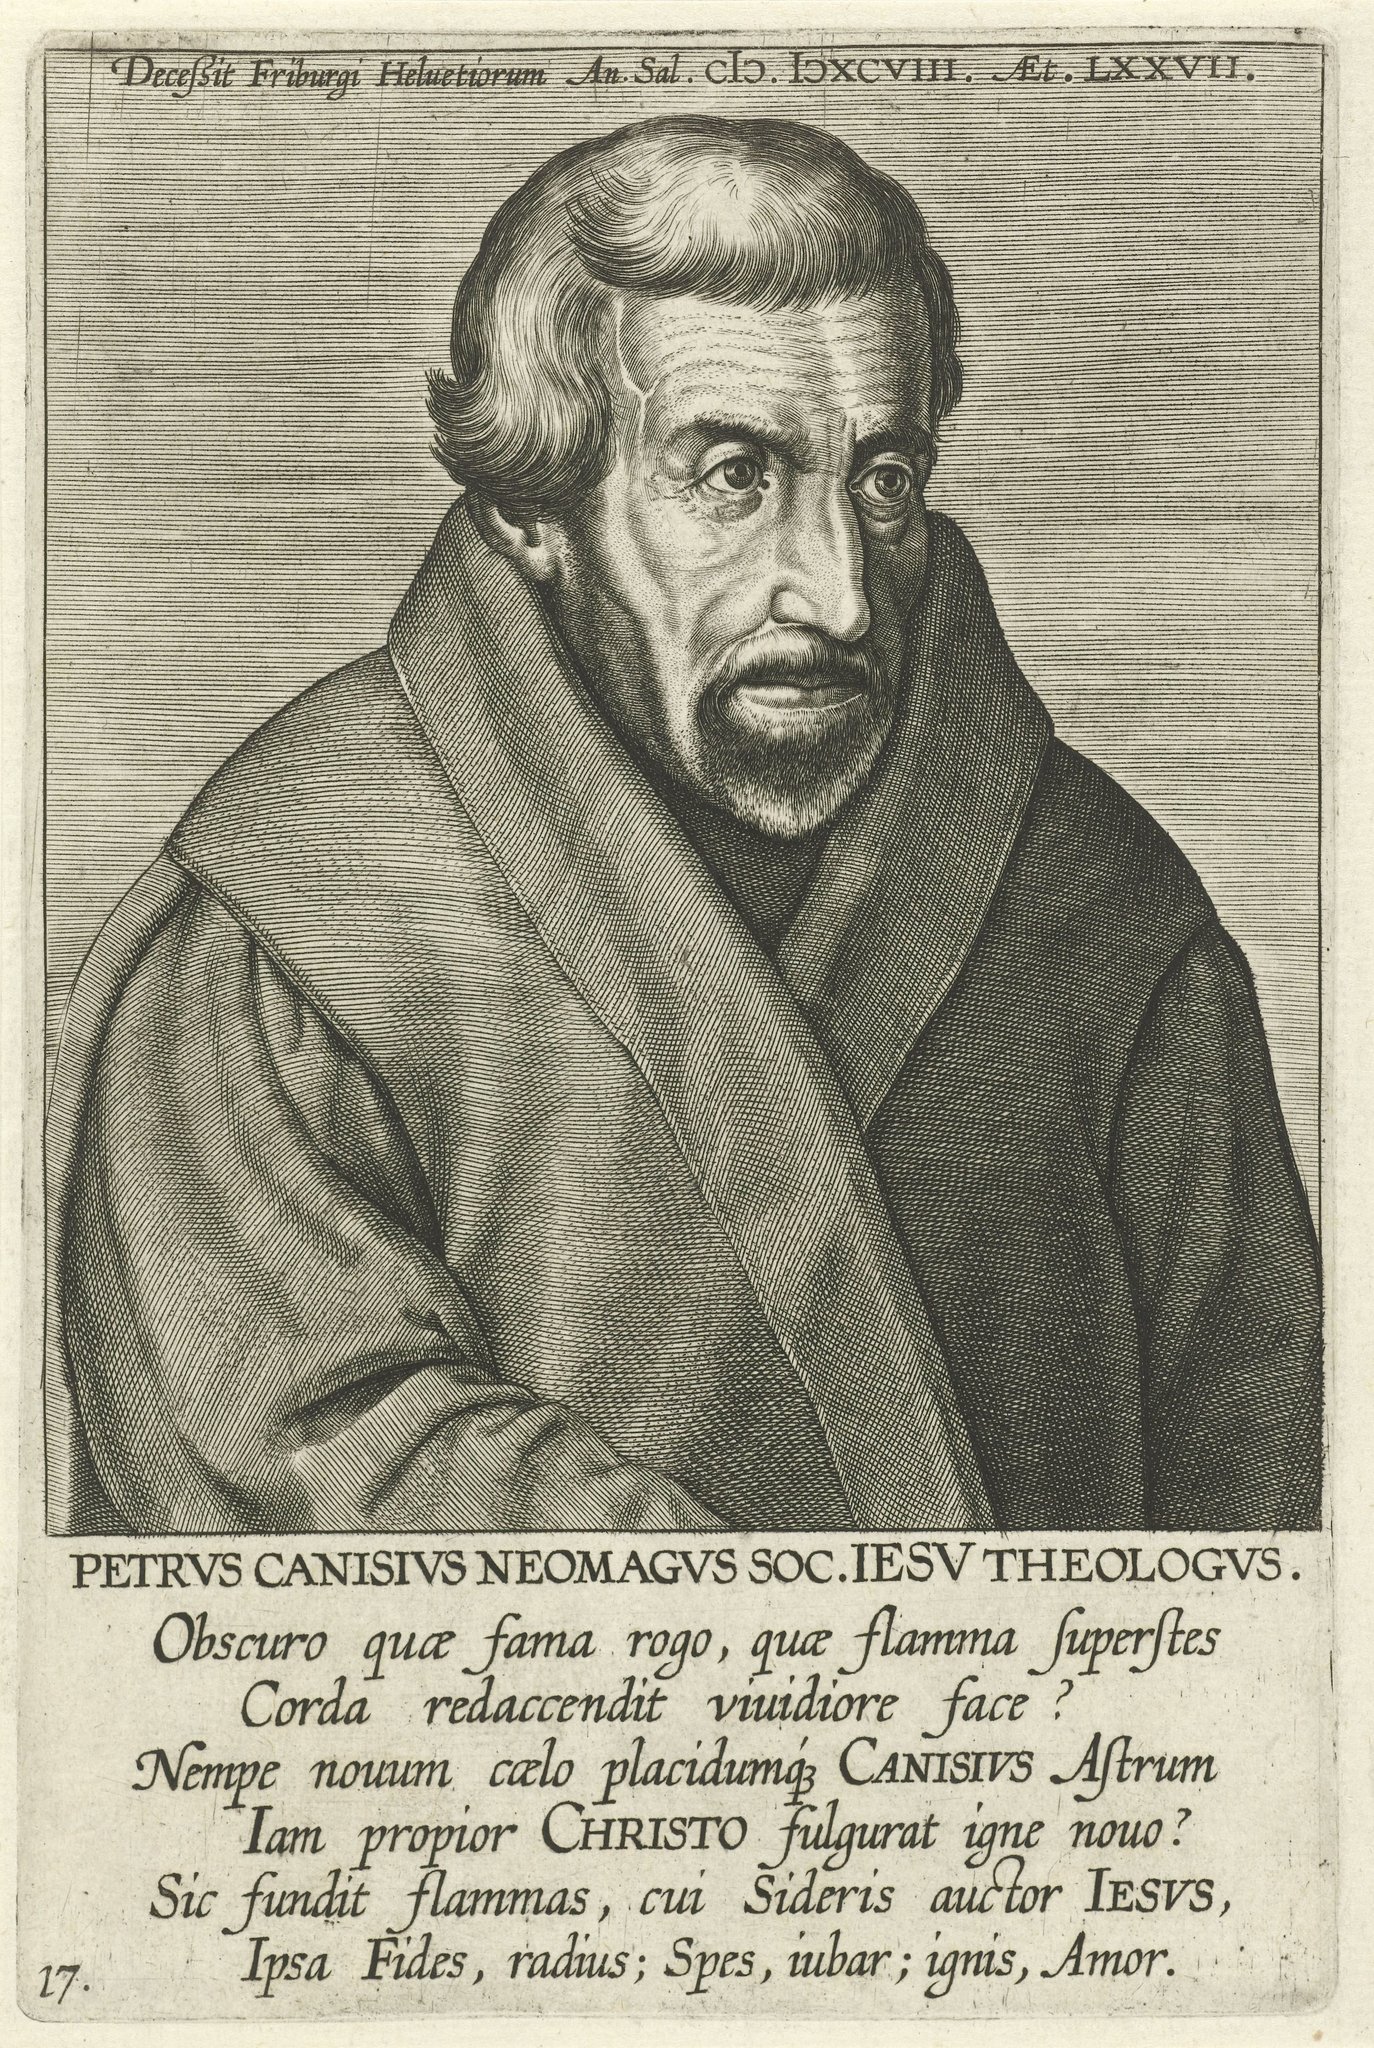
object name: print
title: Portretten van beroemde Nederlandse en Vlaamse geleerden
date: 1604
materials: paper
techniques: engraving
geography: antwerp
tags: nijmegen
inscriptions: collector's mark: Lugt 2228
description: Portret van Petrus Canisius, Nederlandse Jezuïet en theoloog. Buste naar rechts. De prent heeft een Latijns boven- en onderschrift en maakt deel uit van een serie van beroemde Nederlandse en Vlaamse geleerden.